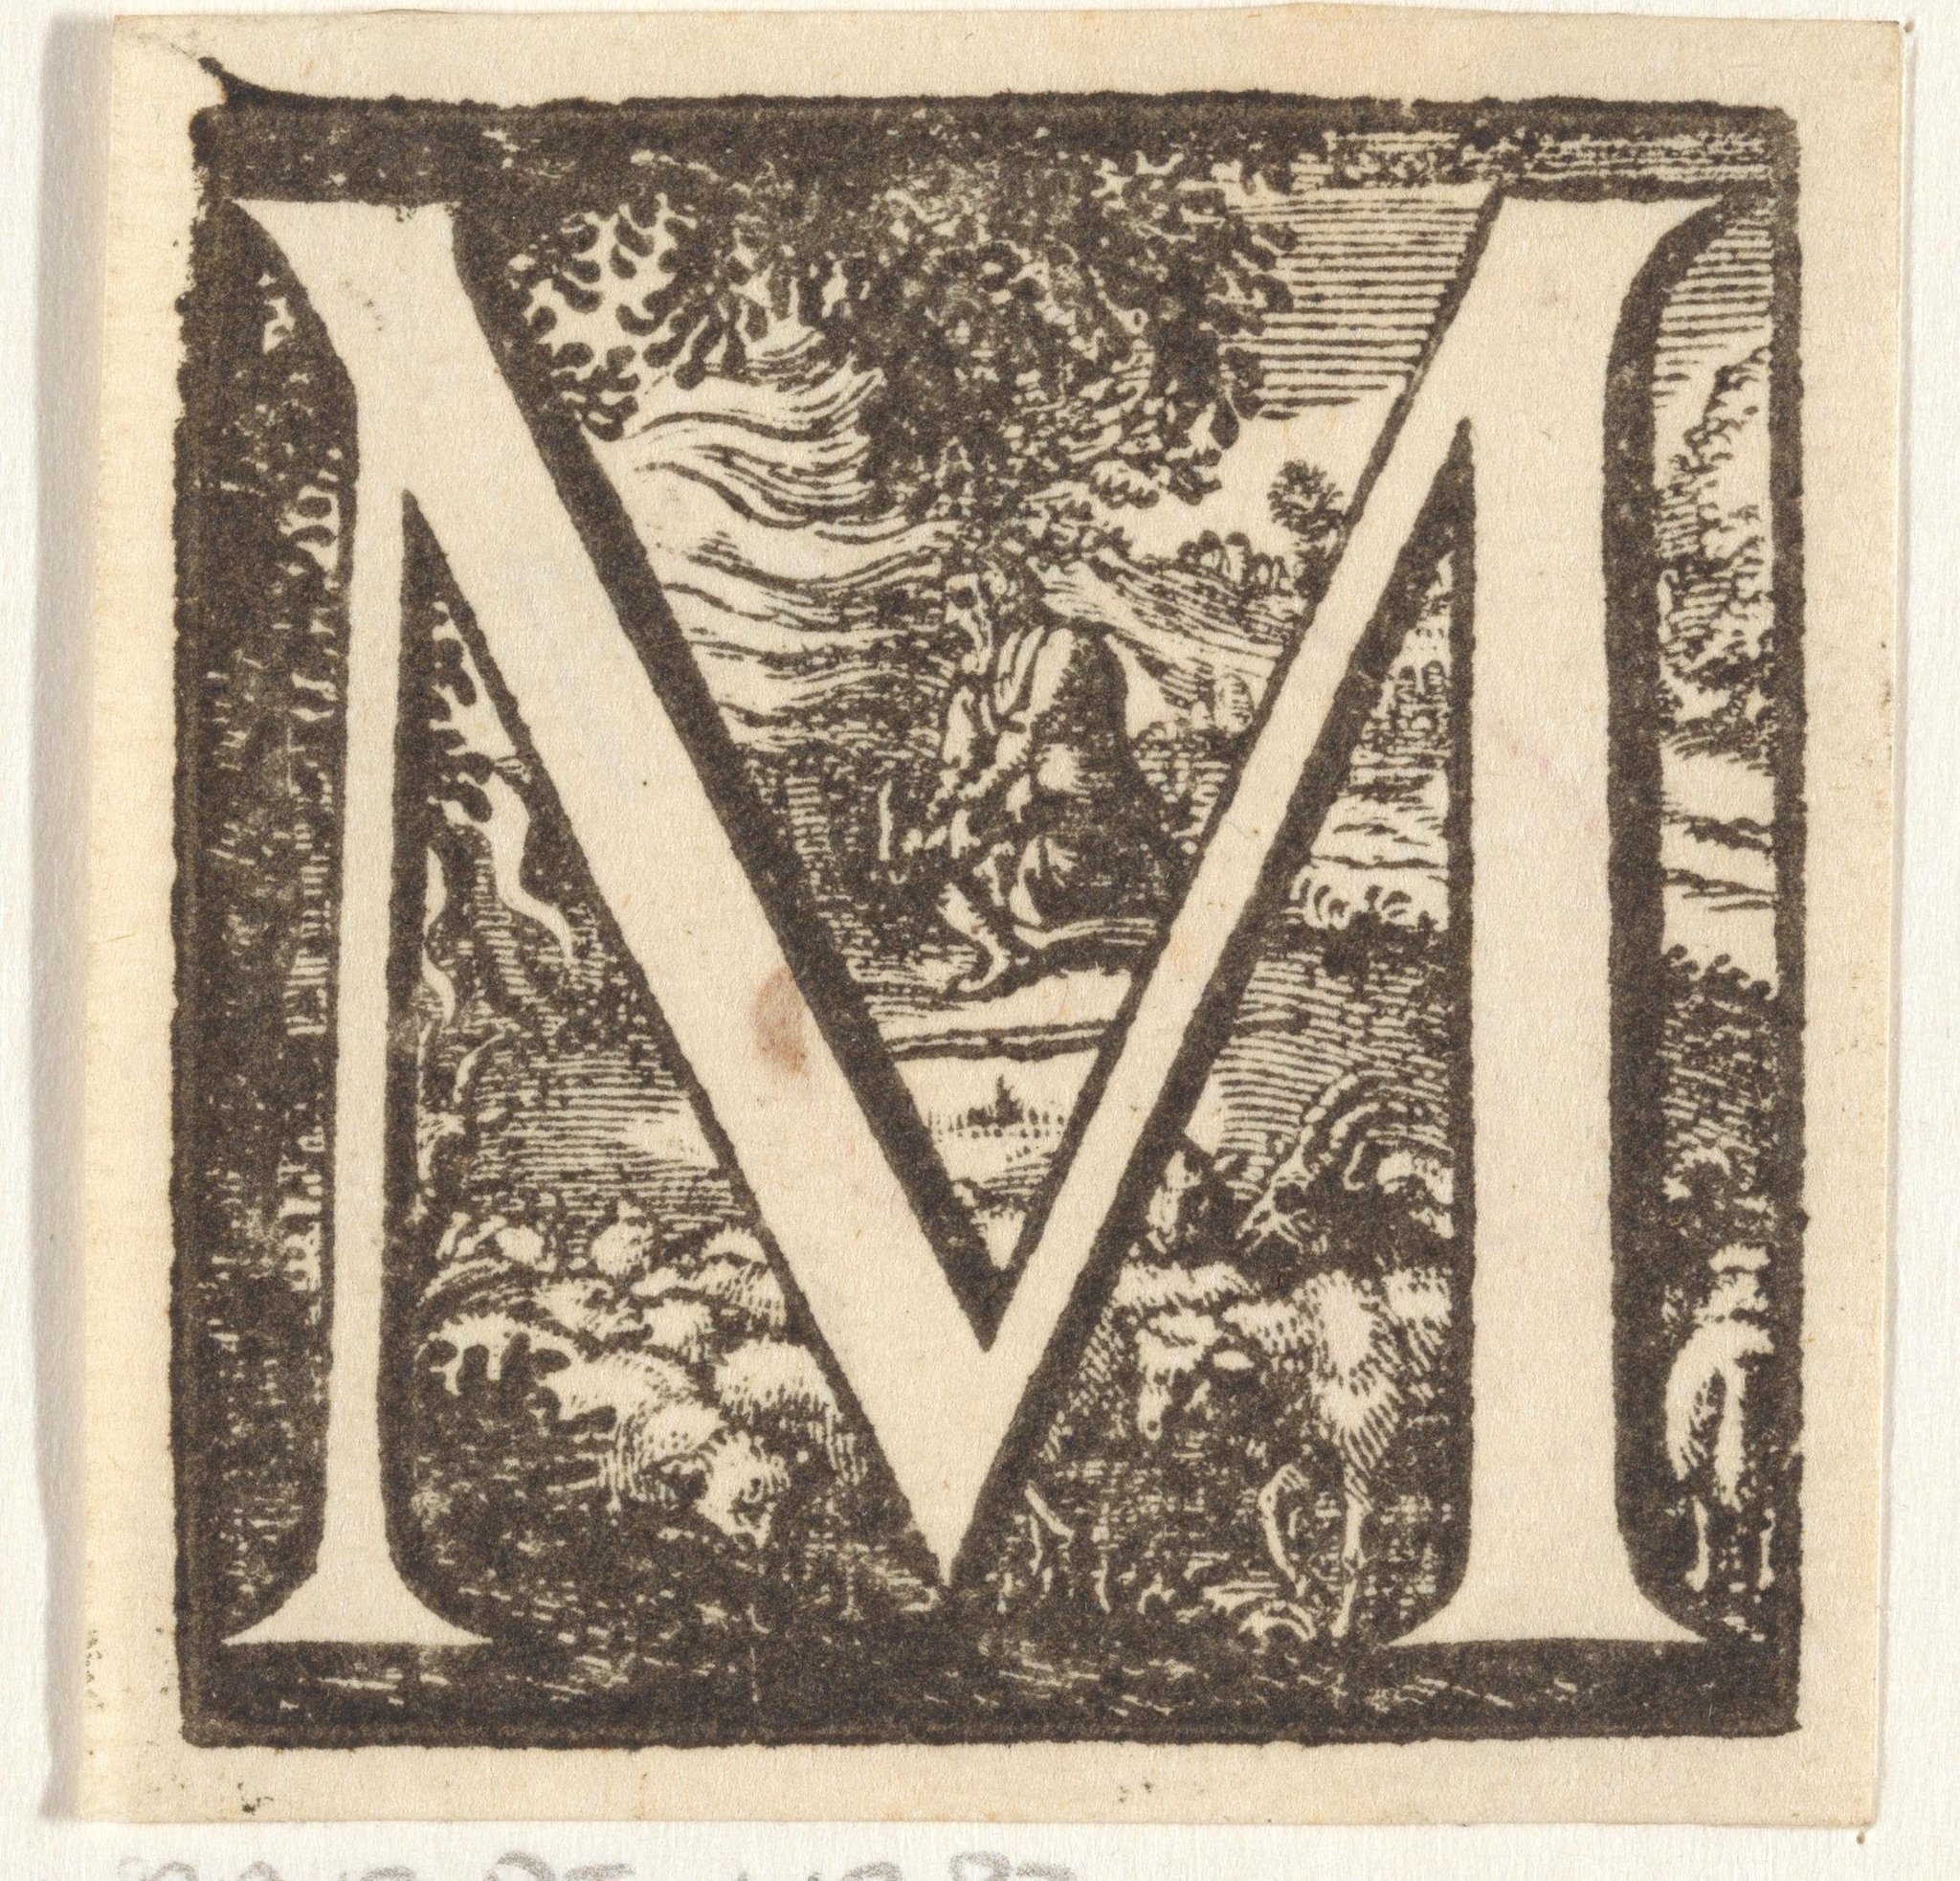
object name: print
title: Letter M in een omlijsting met een bijbelse voorstelling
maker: Anonymous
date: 1600-1699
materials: paper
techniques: woodcut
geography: netherlands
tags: bible, fancy letters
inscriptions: collector's mark: Lugt 240